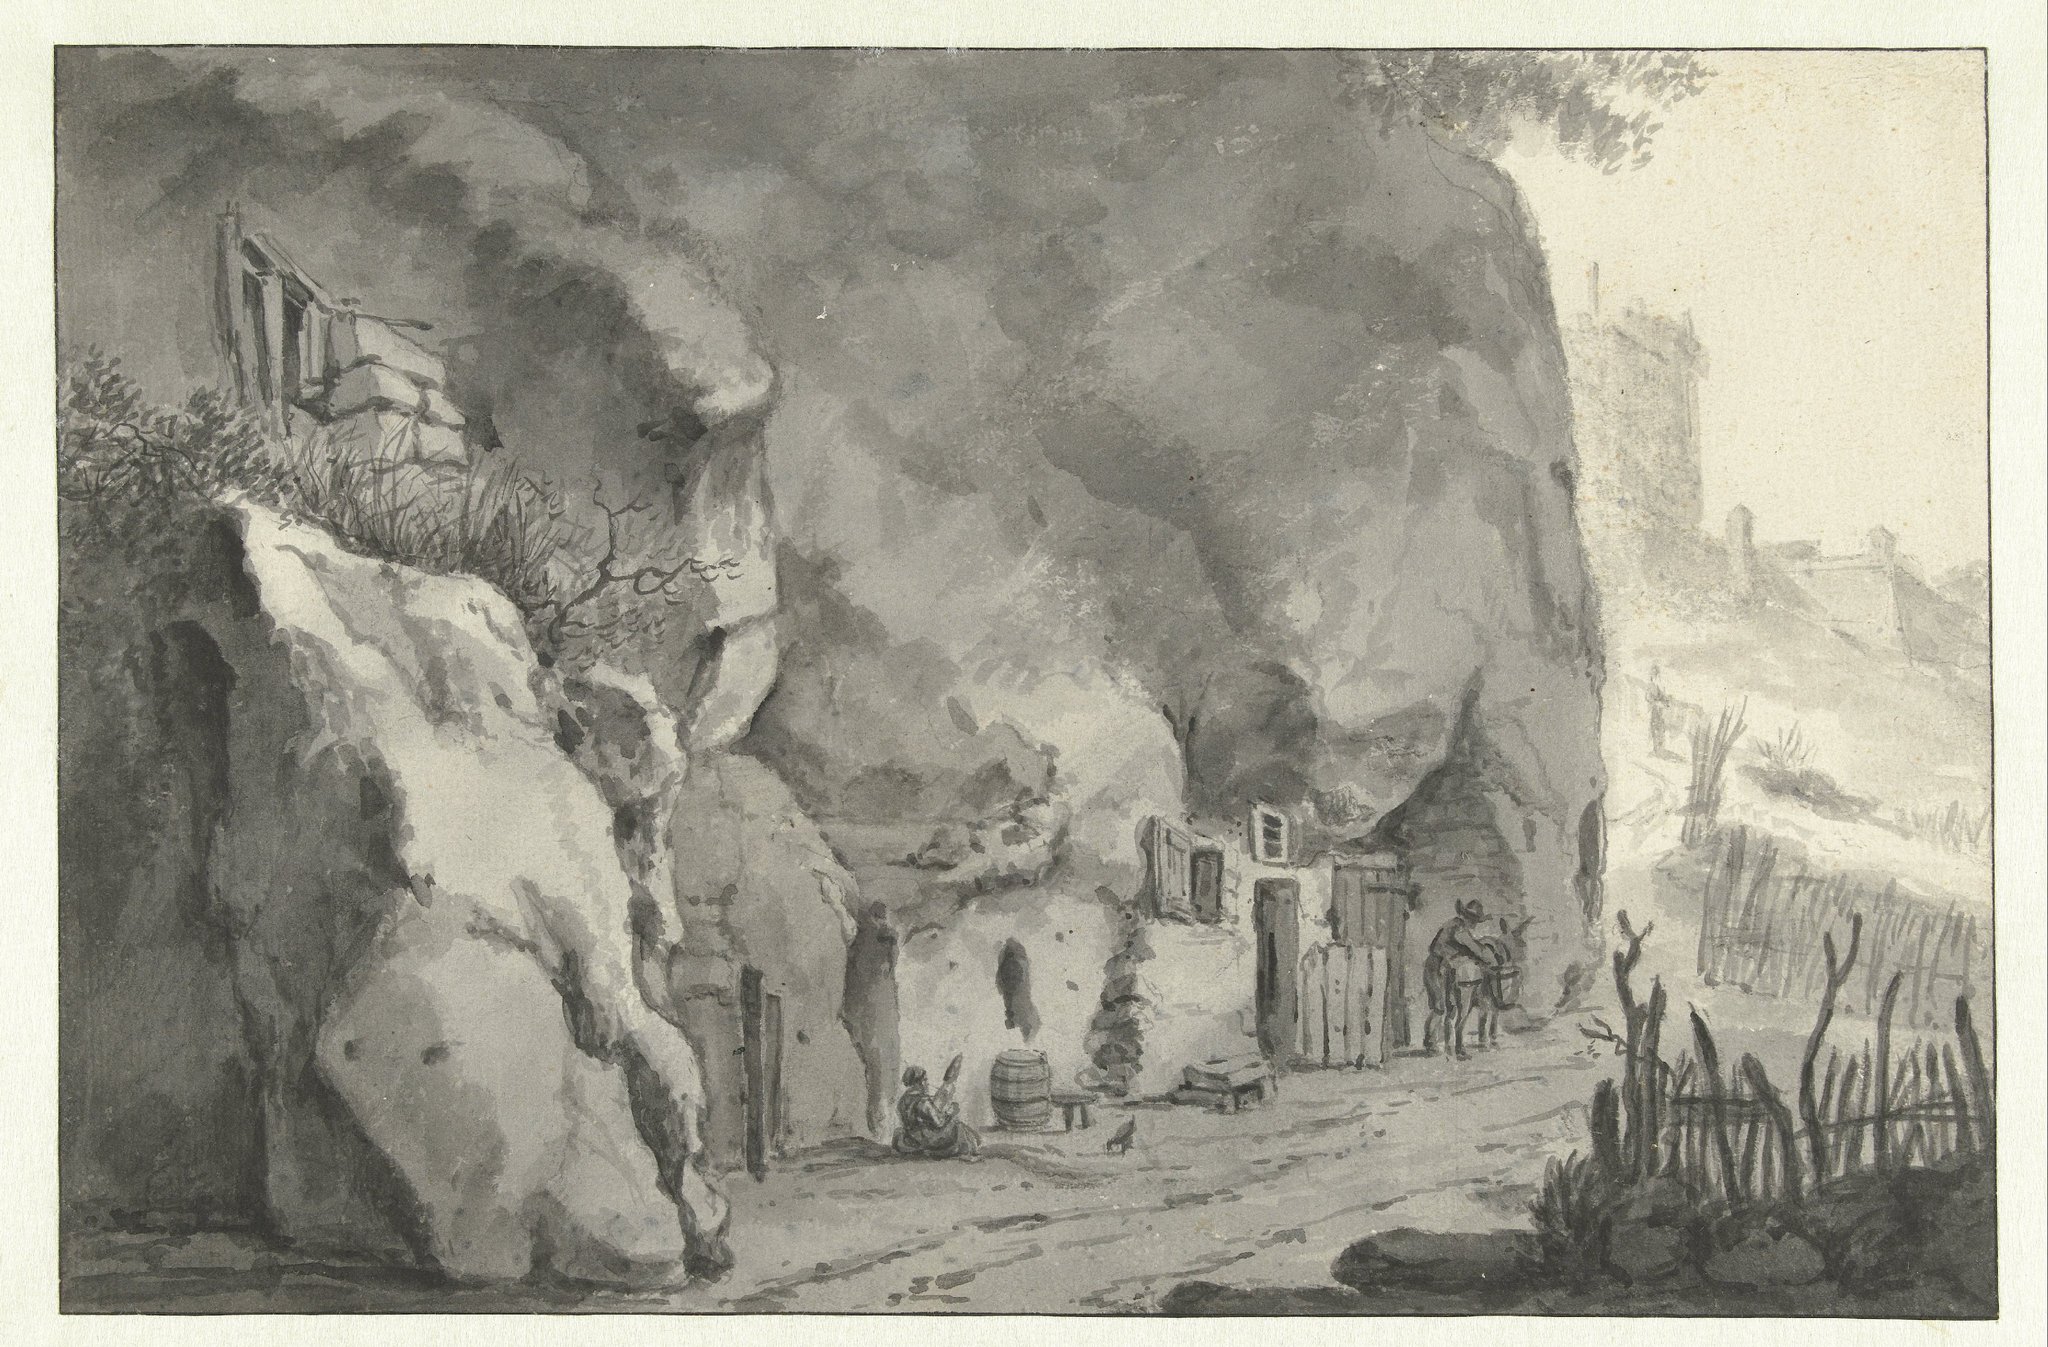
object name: drawing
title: Rotswoningen aan de Loire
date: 1620-1652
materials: chalk, paper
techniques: brush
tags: cave-dwelling